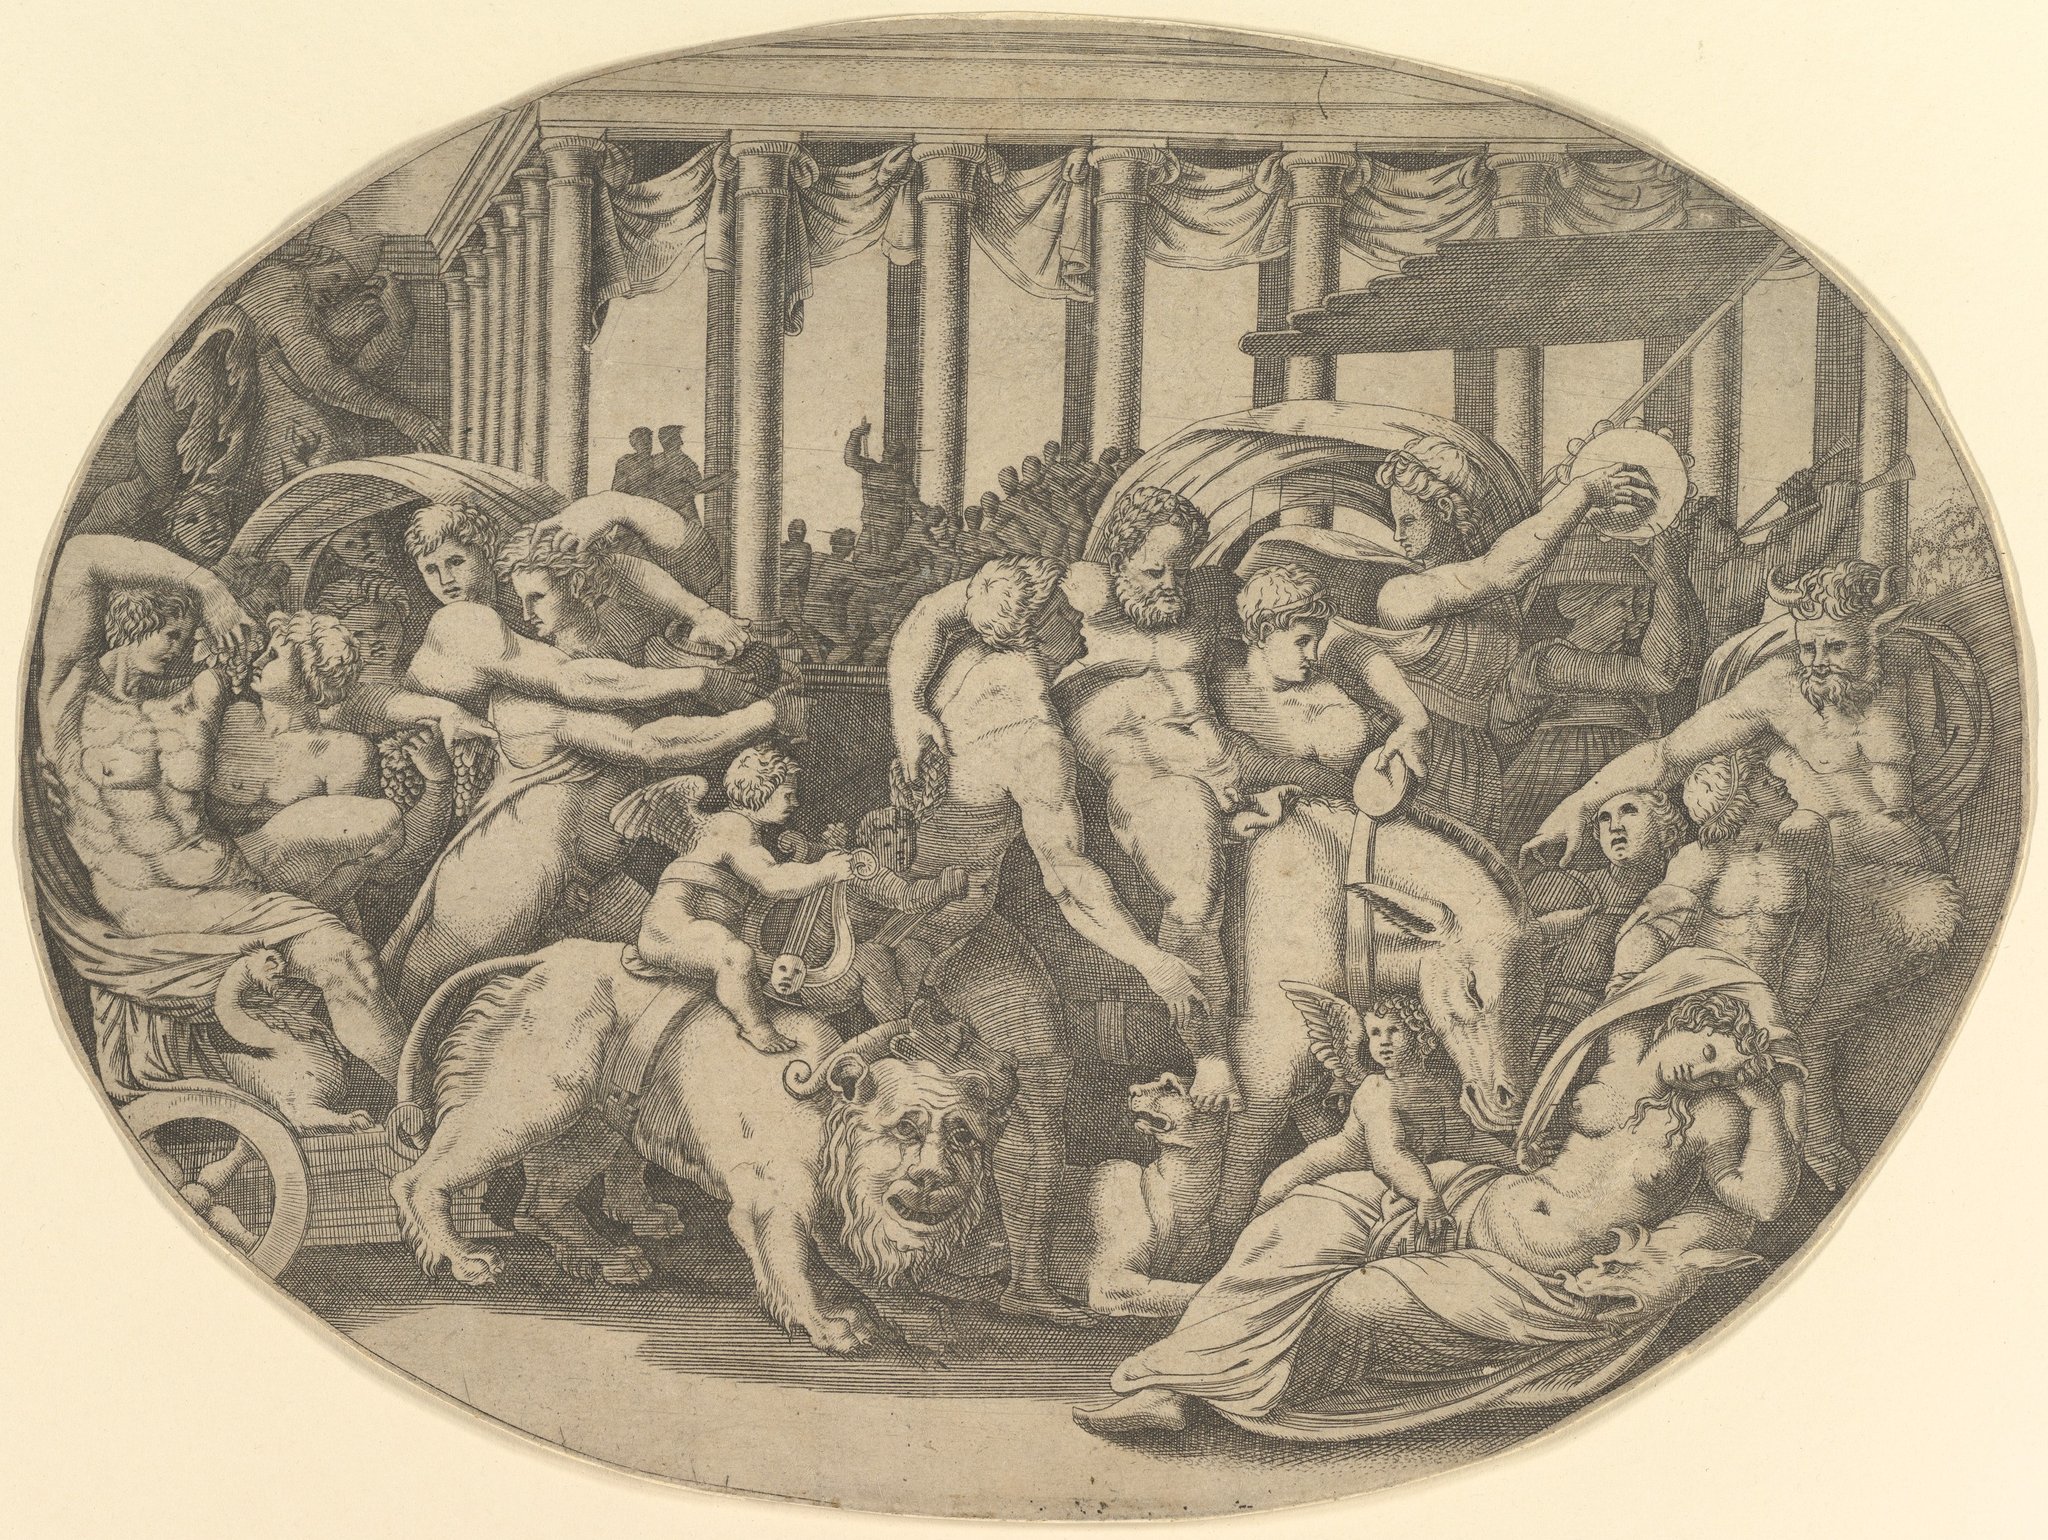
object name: print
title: The Triumph of Bacchus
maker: anonymous, italian?, 16th century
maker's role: artist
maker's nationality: italian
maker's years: 1500-1600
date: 1501-1600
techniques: engraving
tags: male nudes,female nudes,lions